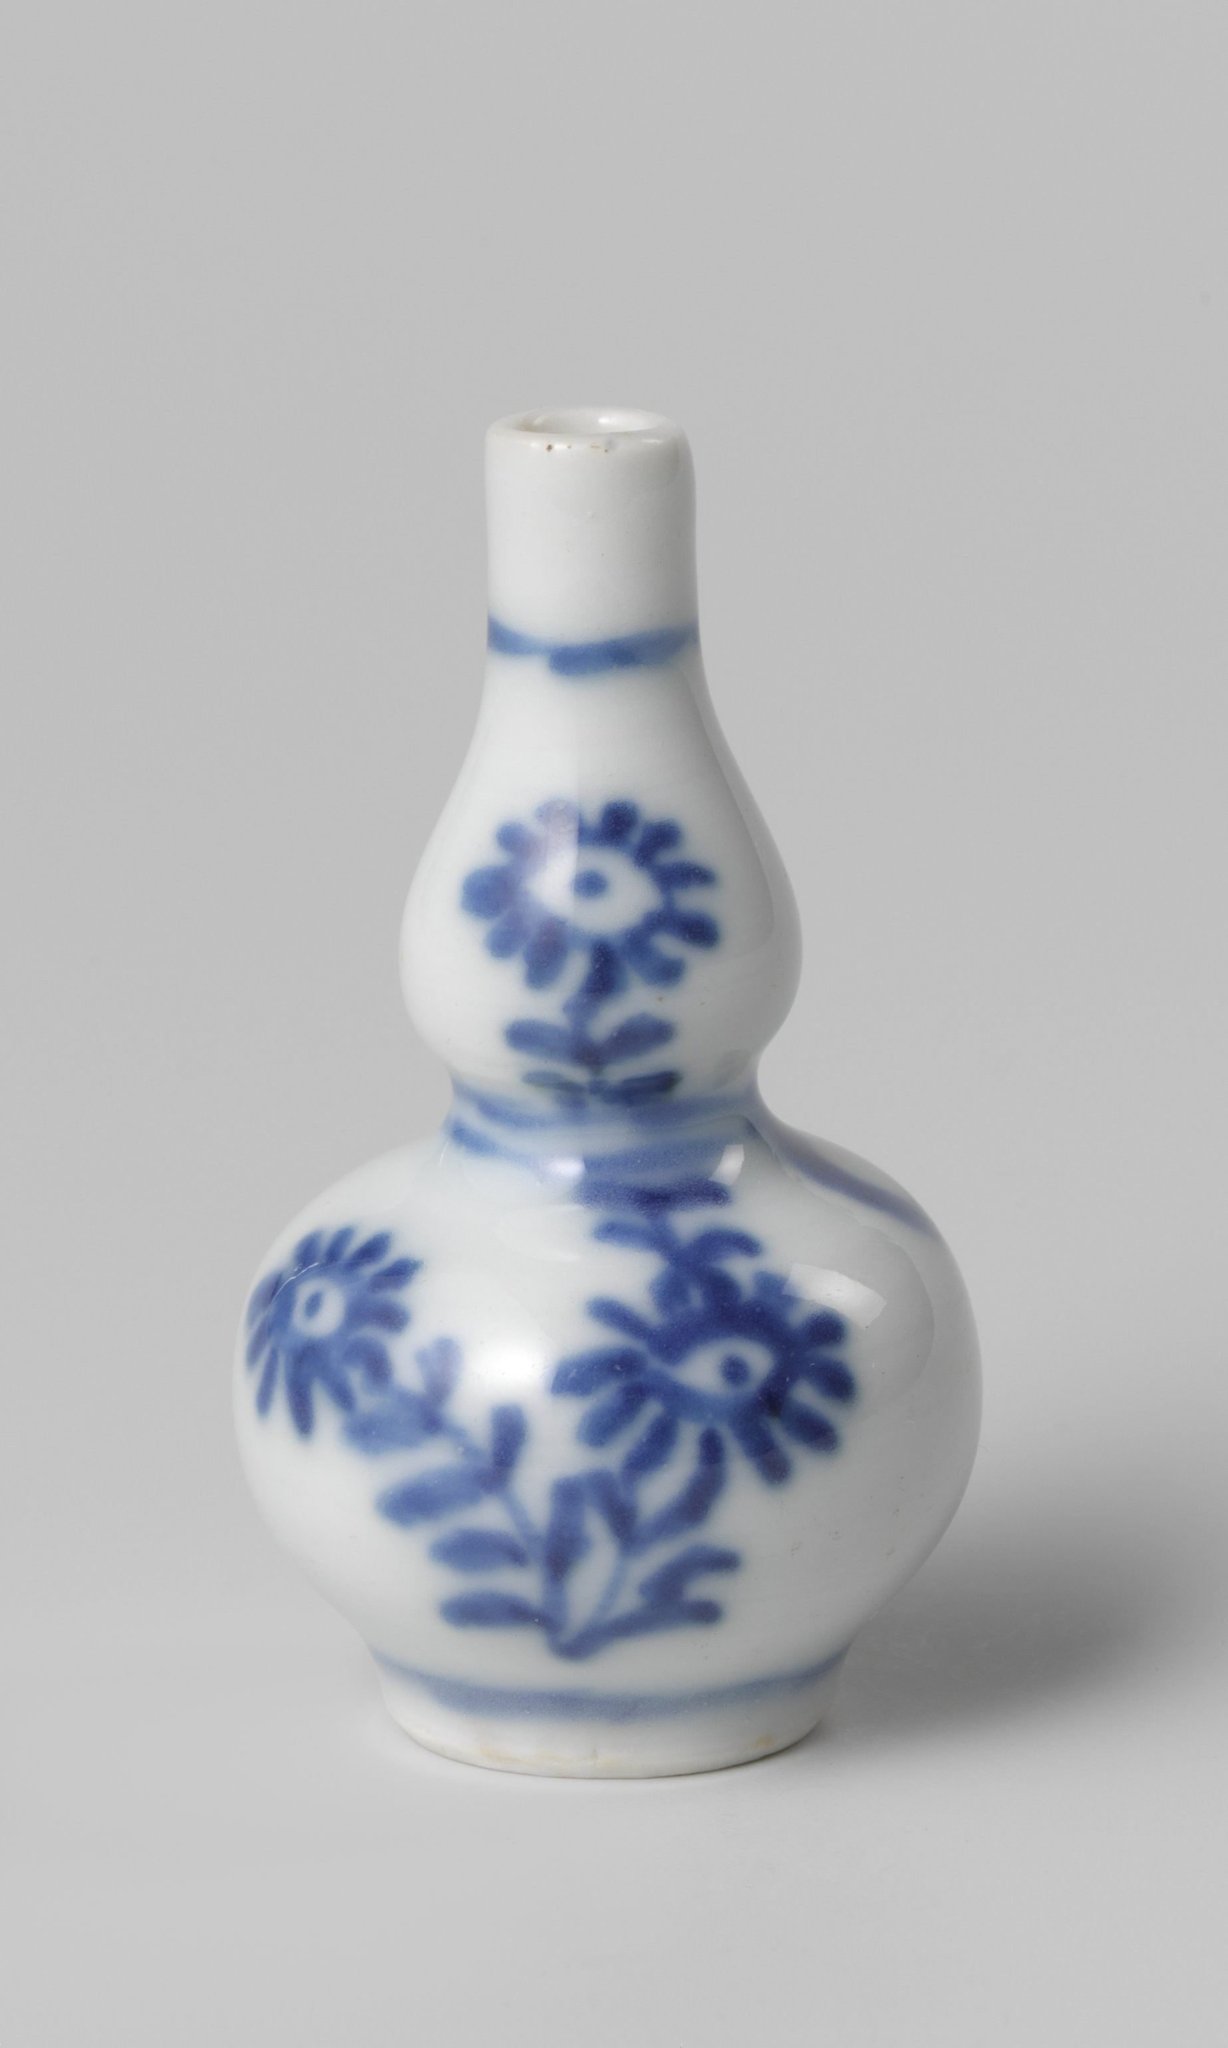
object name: vase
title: Miniature double-gourd vase with flowering plants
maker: Anonymous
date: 1675-1724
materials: cobalt, glaze, paint, porcelain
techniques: firing, turning, vitrification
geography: china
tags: ornament derived from plant forms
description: Miniatuur kalebasvormige vaas van porselein, beschilderd in onderglazuur blauw. Op de wand bloeiende planten (aster) en een strik. Blauw-wit.